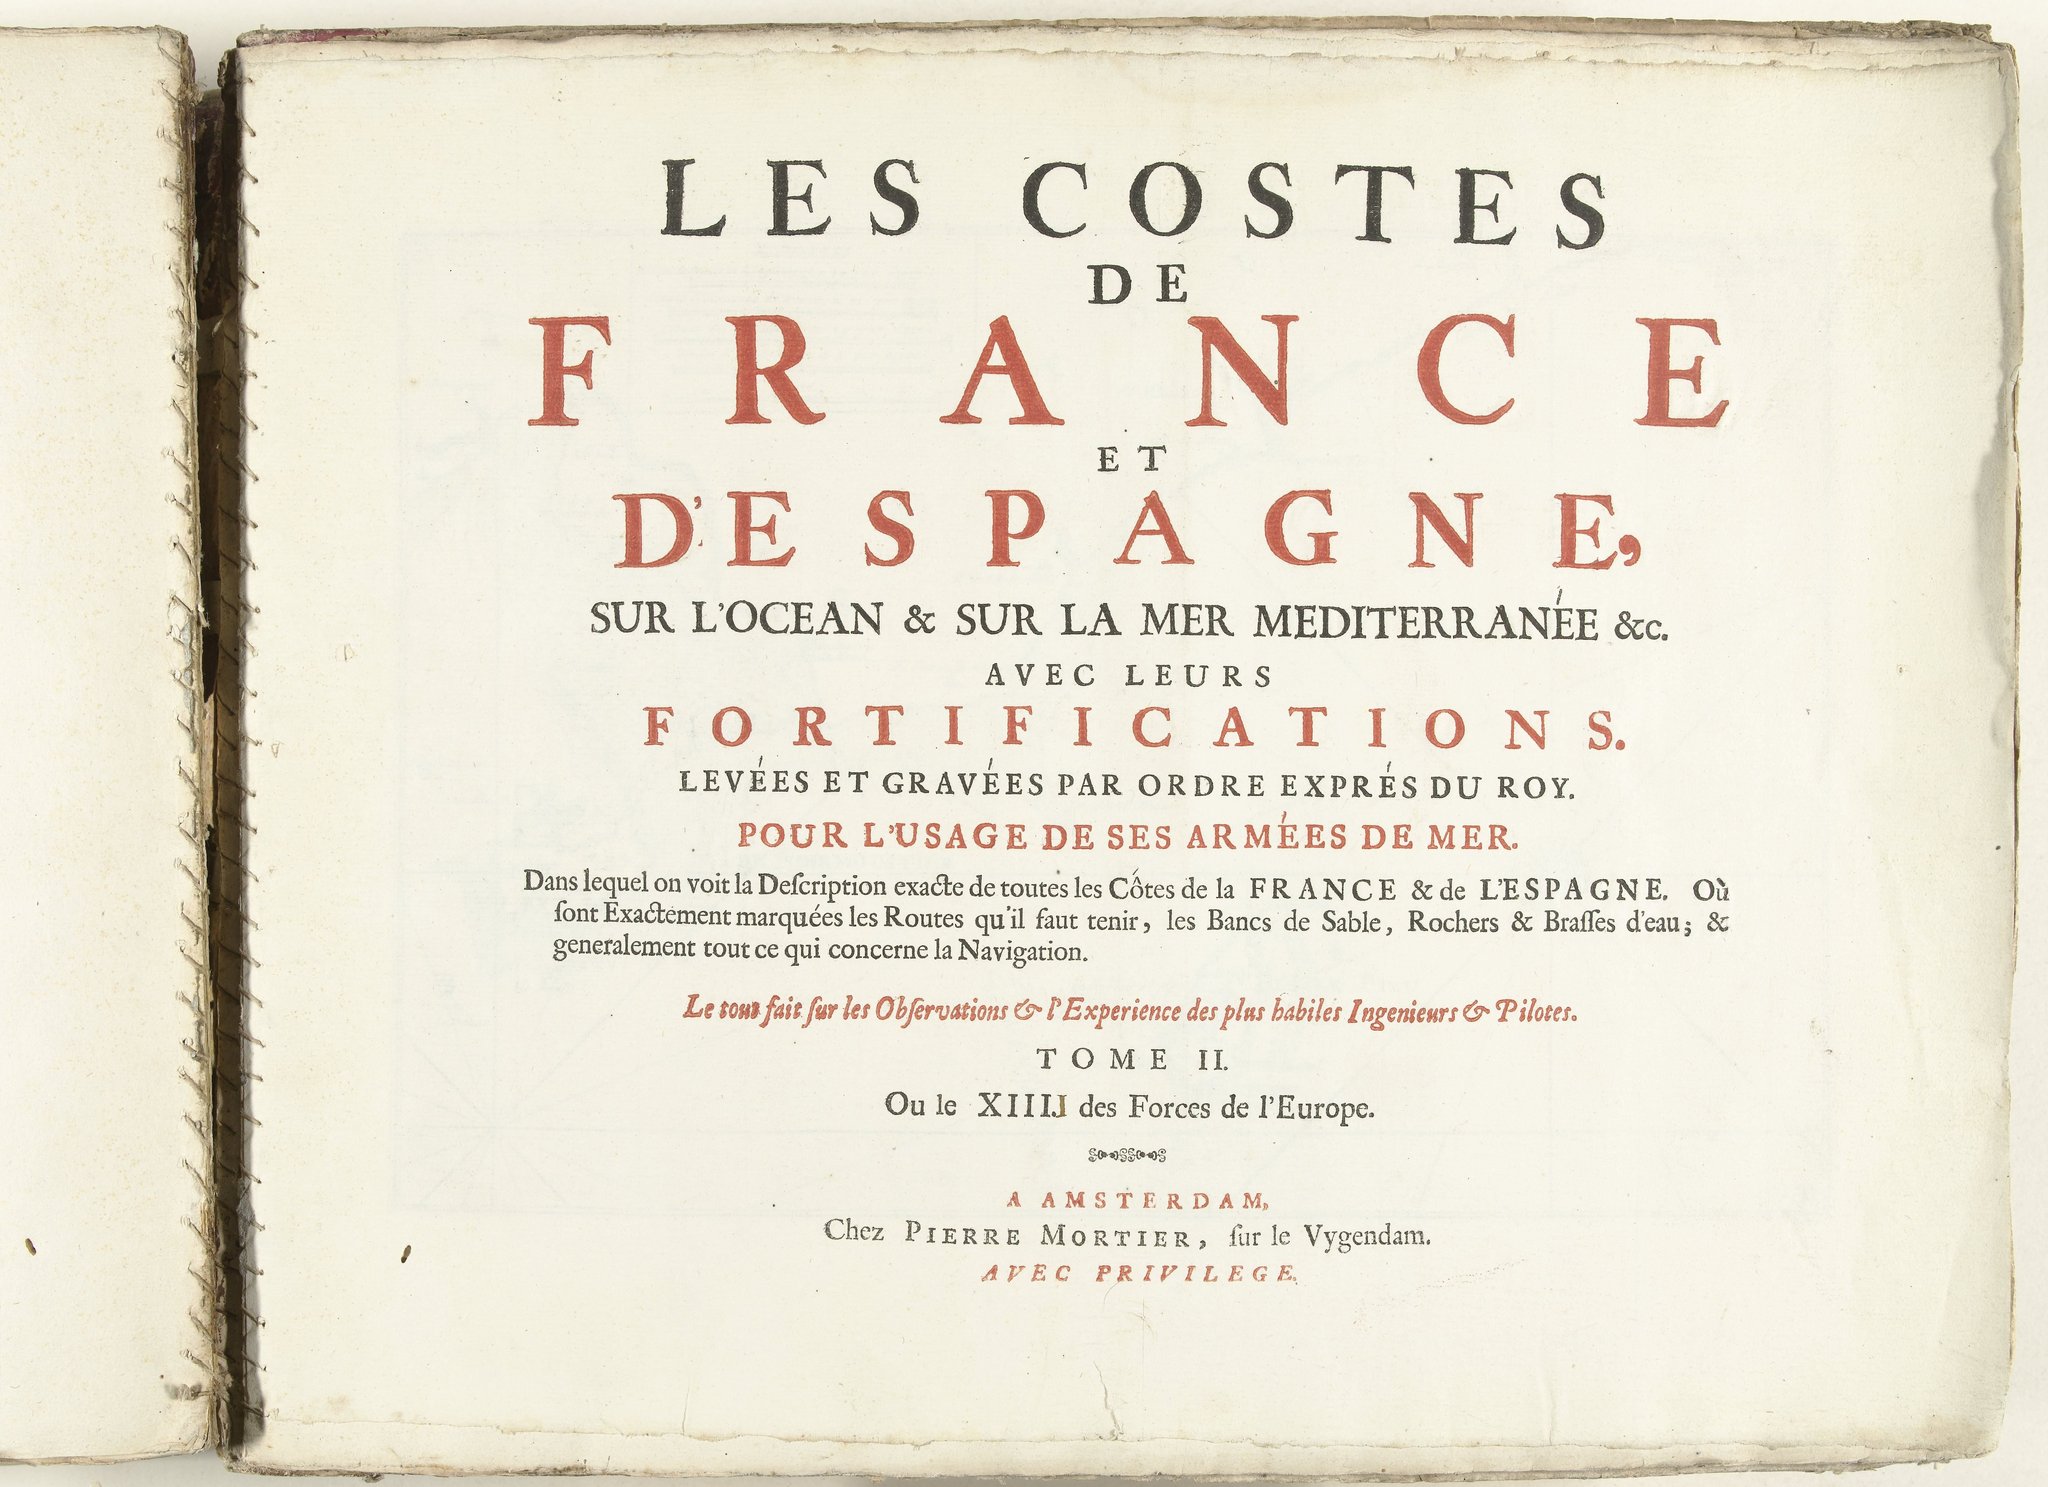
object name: titelblad, titelpagina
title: Titelpagina voor het tweede deel van het prentwerk: Les costes de France et d'Espagne, ca. 1702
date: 1702-1703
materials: paper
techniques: letterpress printing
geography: amsterdam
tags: spaanse successieoorlog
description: Titelpagina gedrukt in zwart en rood voor het tweede van twee delen van het prentwerk: Les costes de France et d'Espagne, oftewel deel 14 van: Les Forces de l'Europe, Asie, Afrique et Amerique, uitgegeven ca. 1702. Het prentwerk bestaat in totaal uit 43 gemerkte platen van de kust van Frankrijk en Spanje, in het kader van de Spaanse Successieoorlog. Deze platen zijn gekopieerd naar anonieme Franse platen oorspronkelijk uitgegeven door Nicolas de Fer te Parijs. Titel in het Frans.